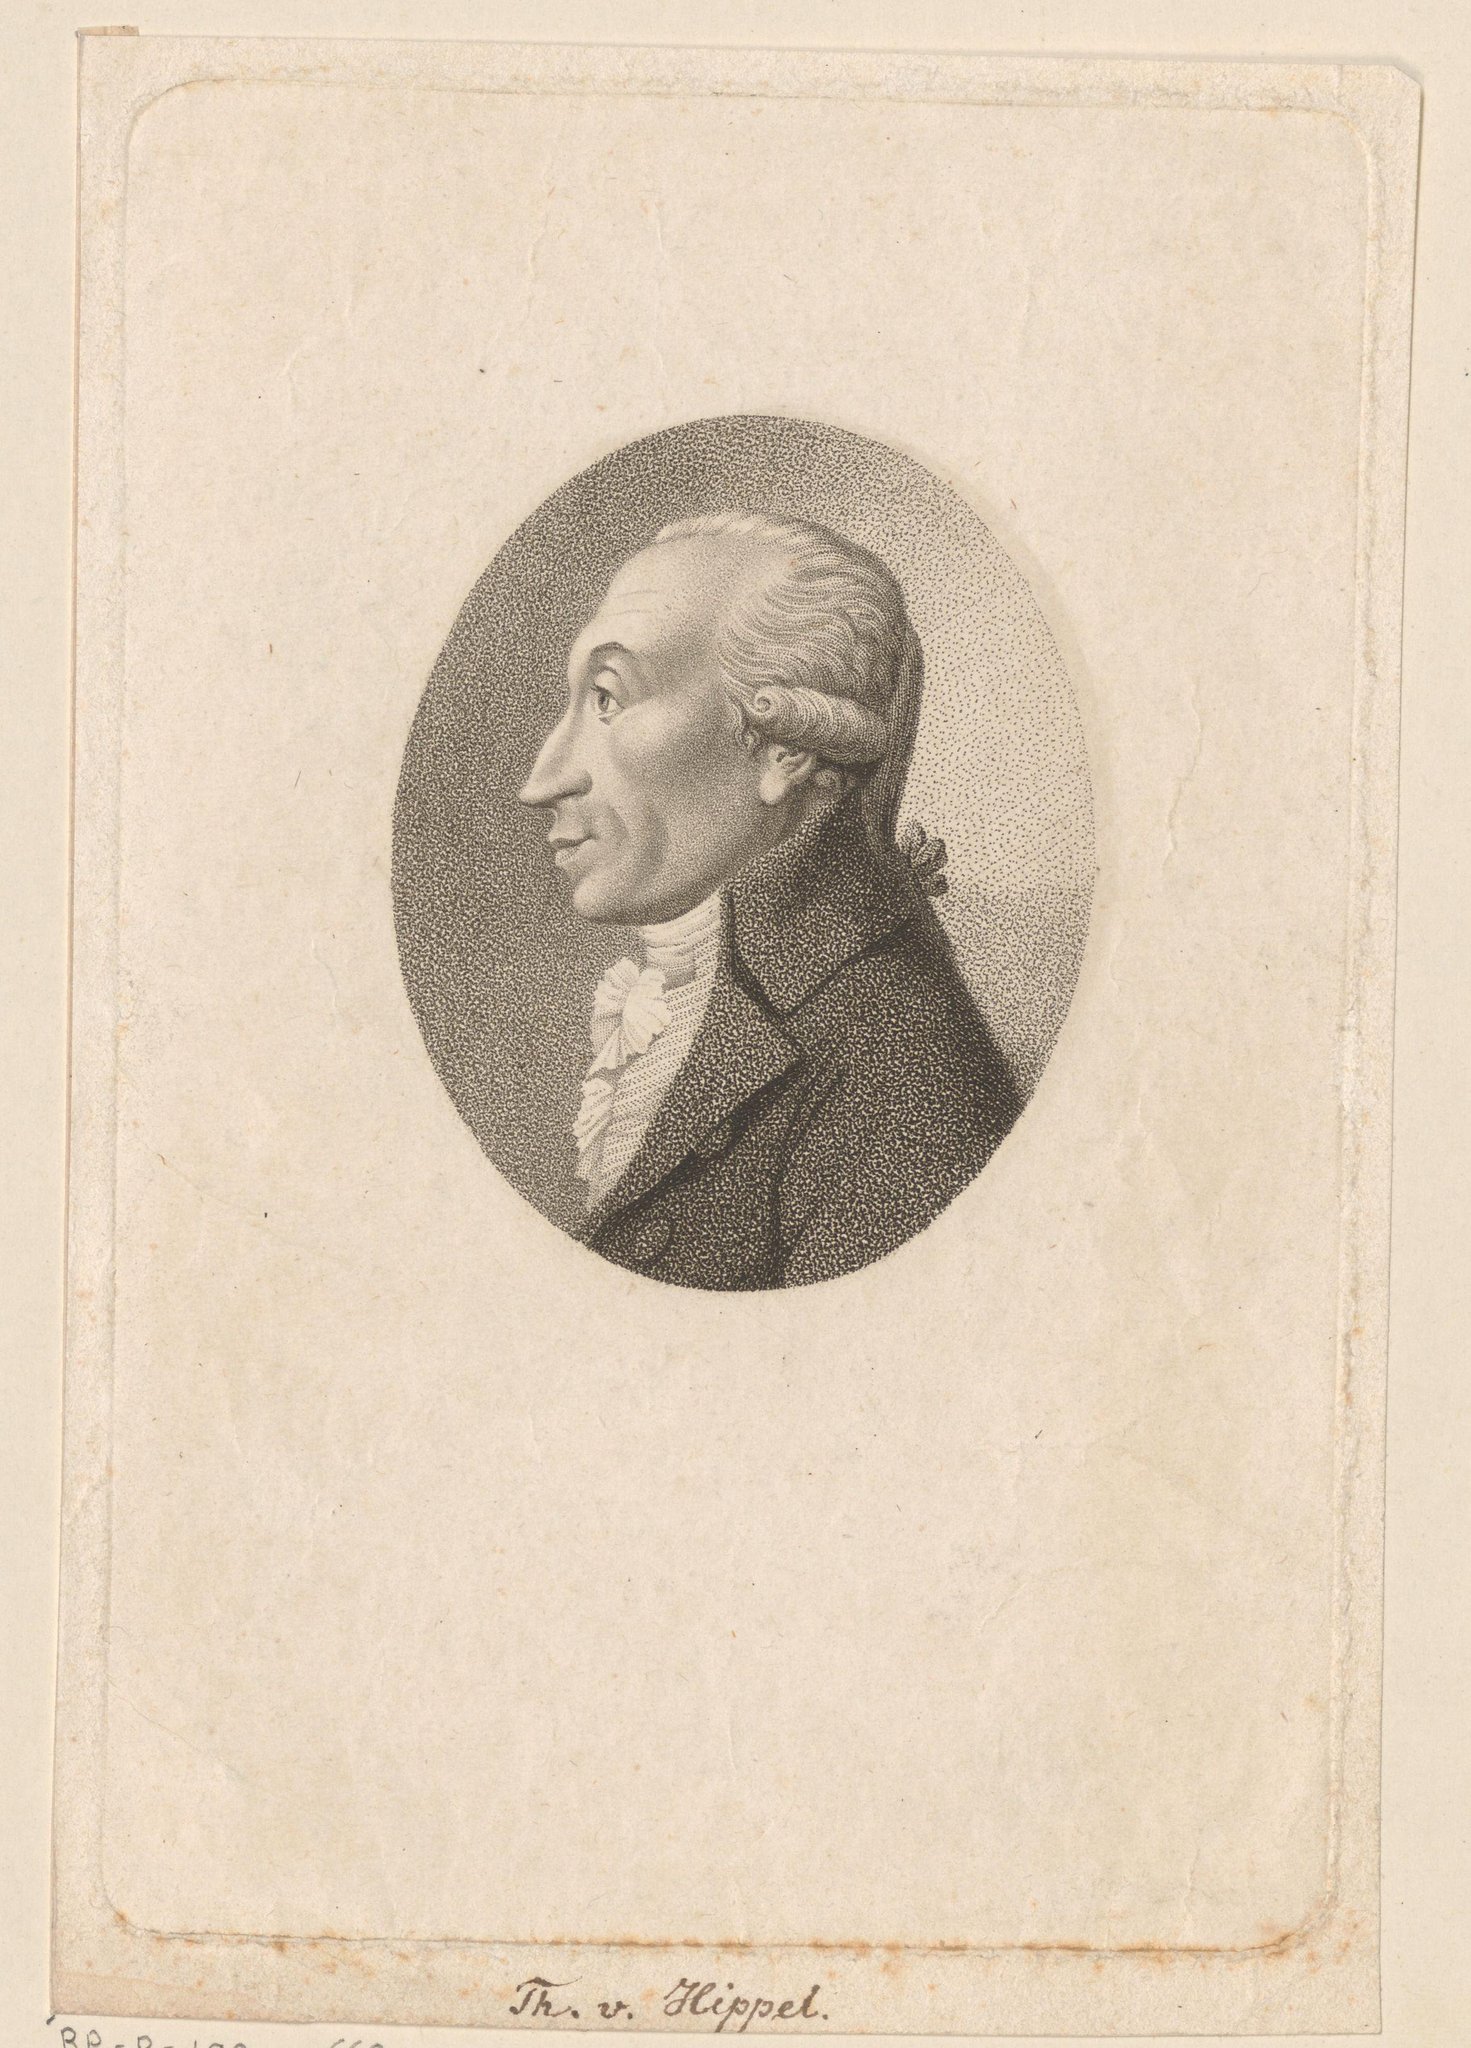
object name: print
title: Portret van Theodor Gottlieb von Hippel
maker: johann friedrich bolt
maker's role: print maker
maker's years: 1769-1836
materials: paper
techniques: stippling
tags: historical persons, portrait of a writer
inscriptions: collector's mark: Lugt 2228, inscription: ‘Th. v. Hippel.’